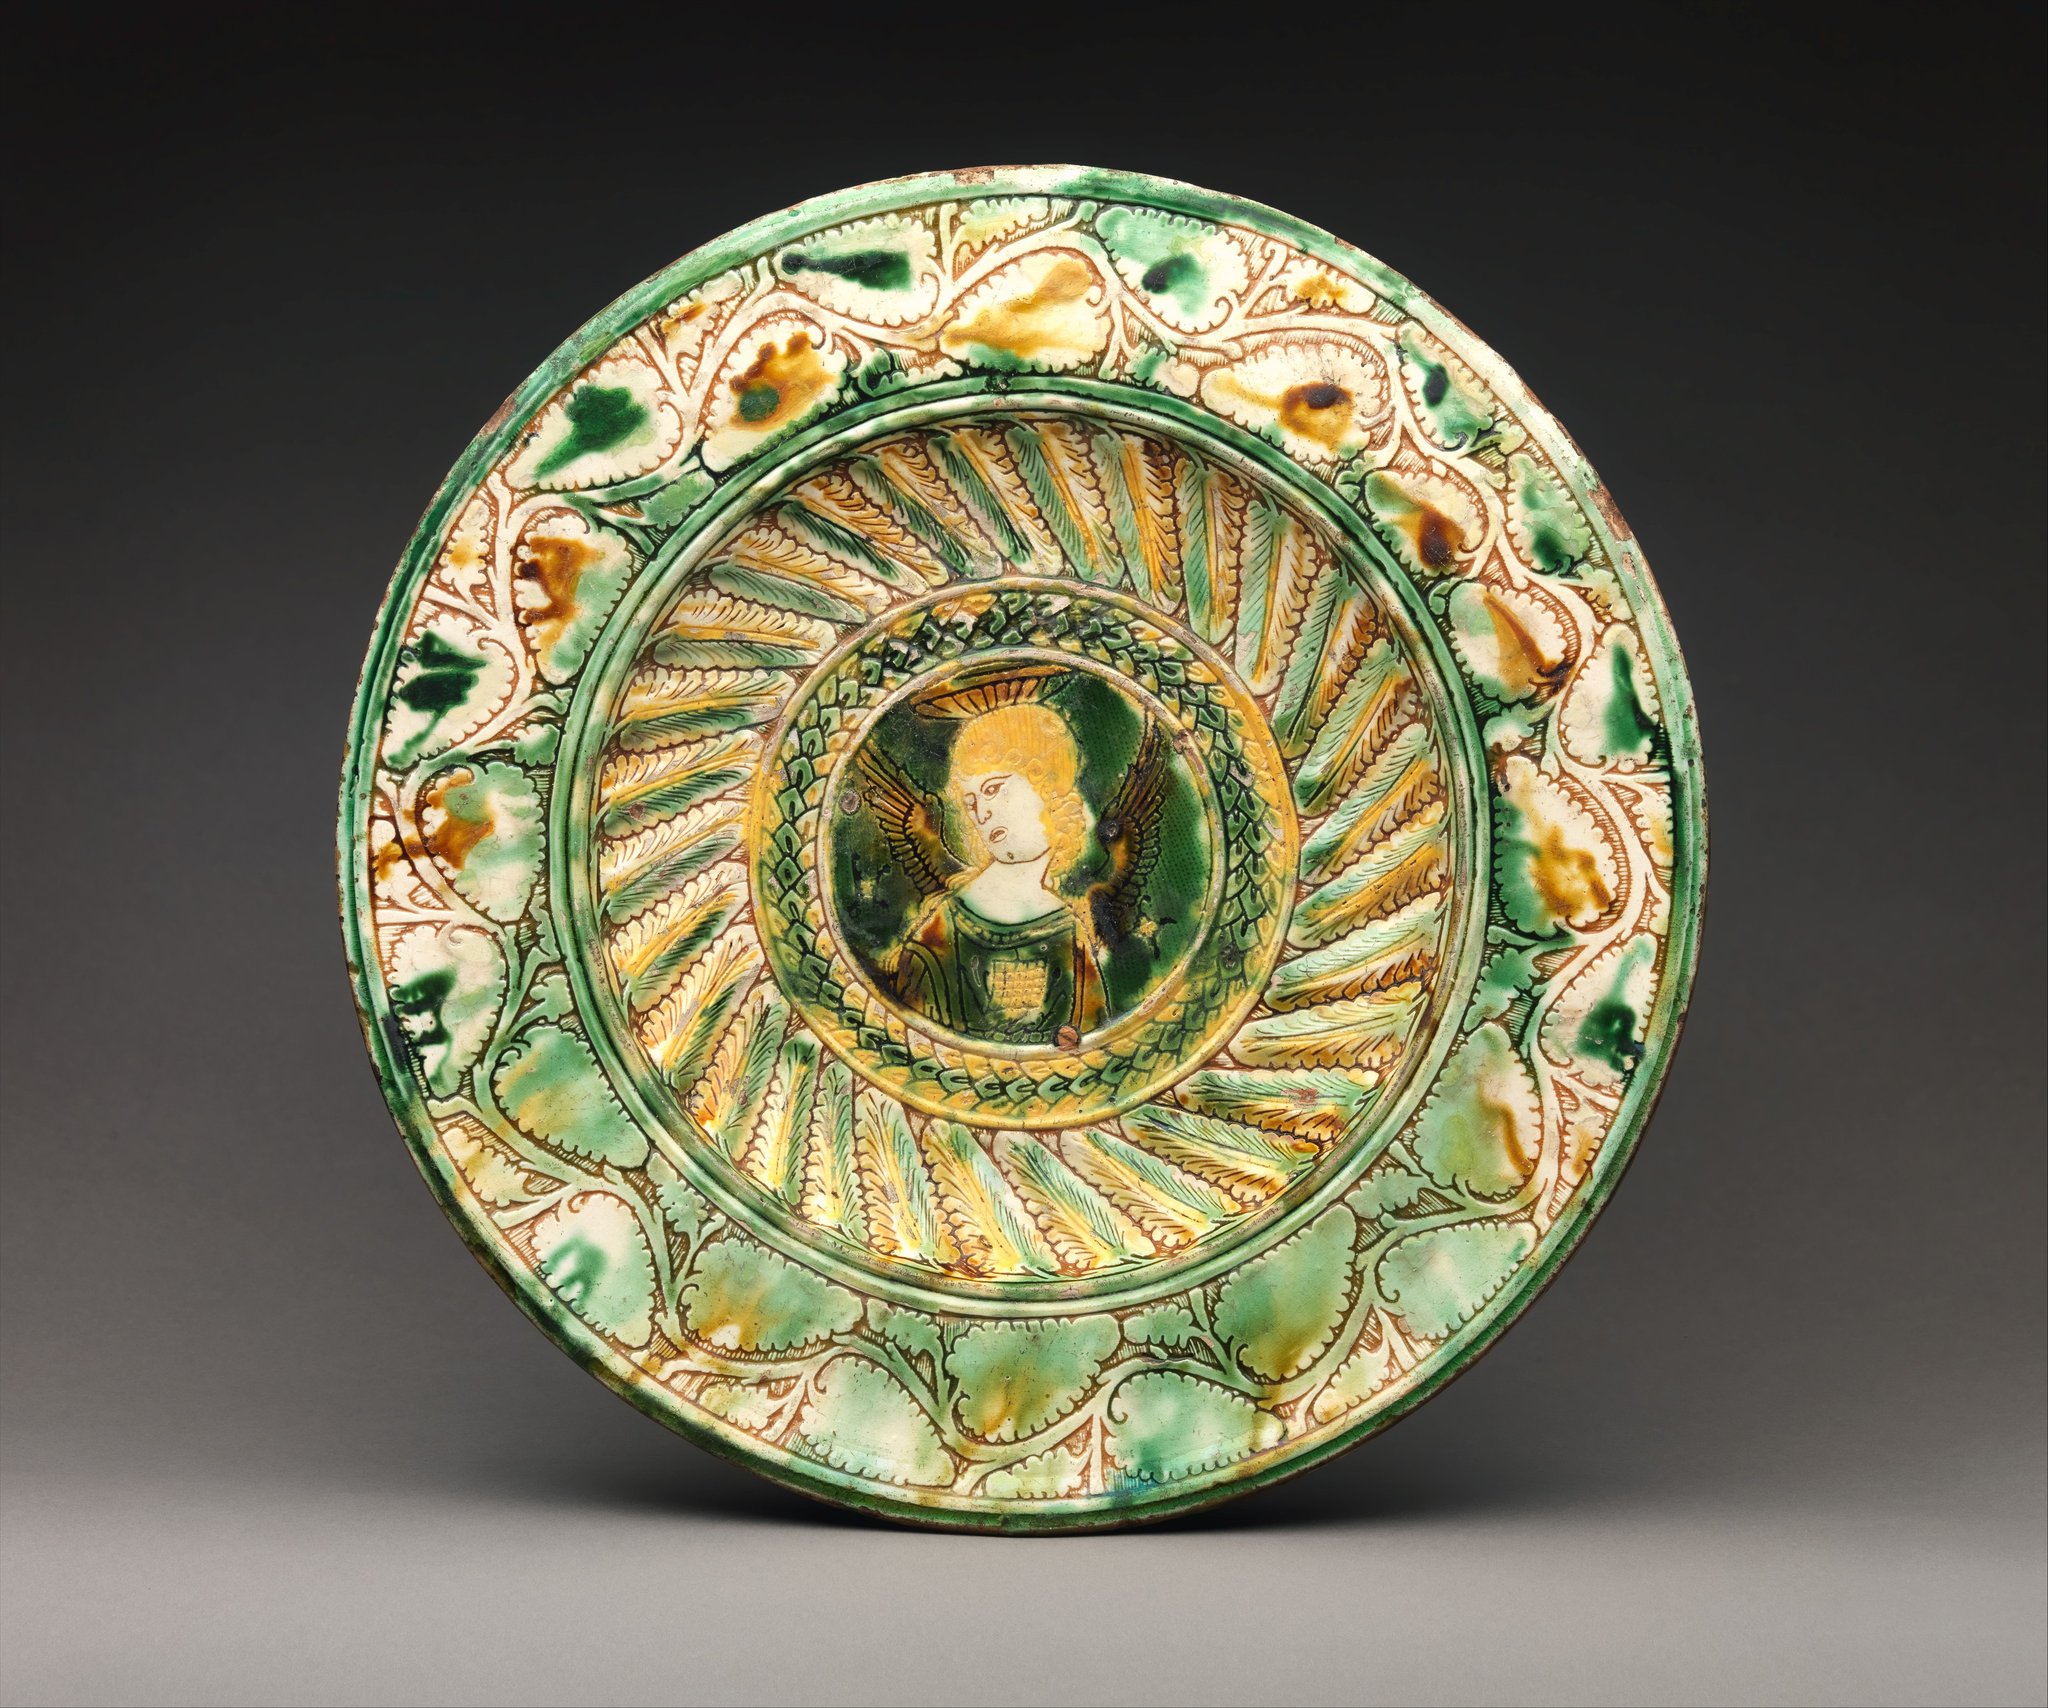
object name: plate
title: Plate with angels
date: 1480-1500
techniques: incising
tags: angels